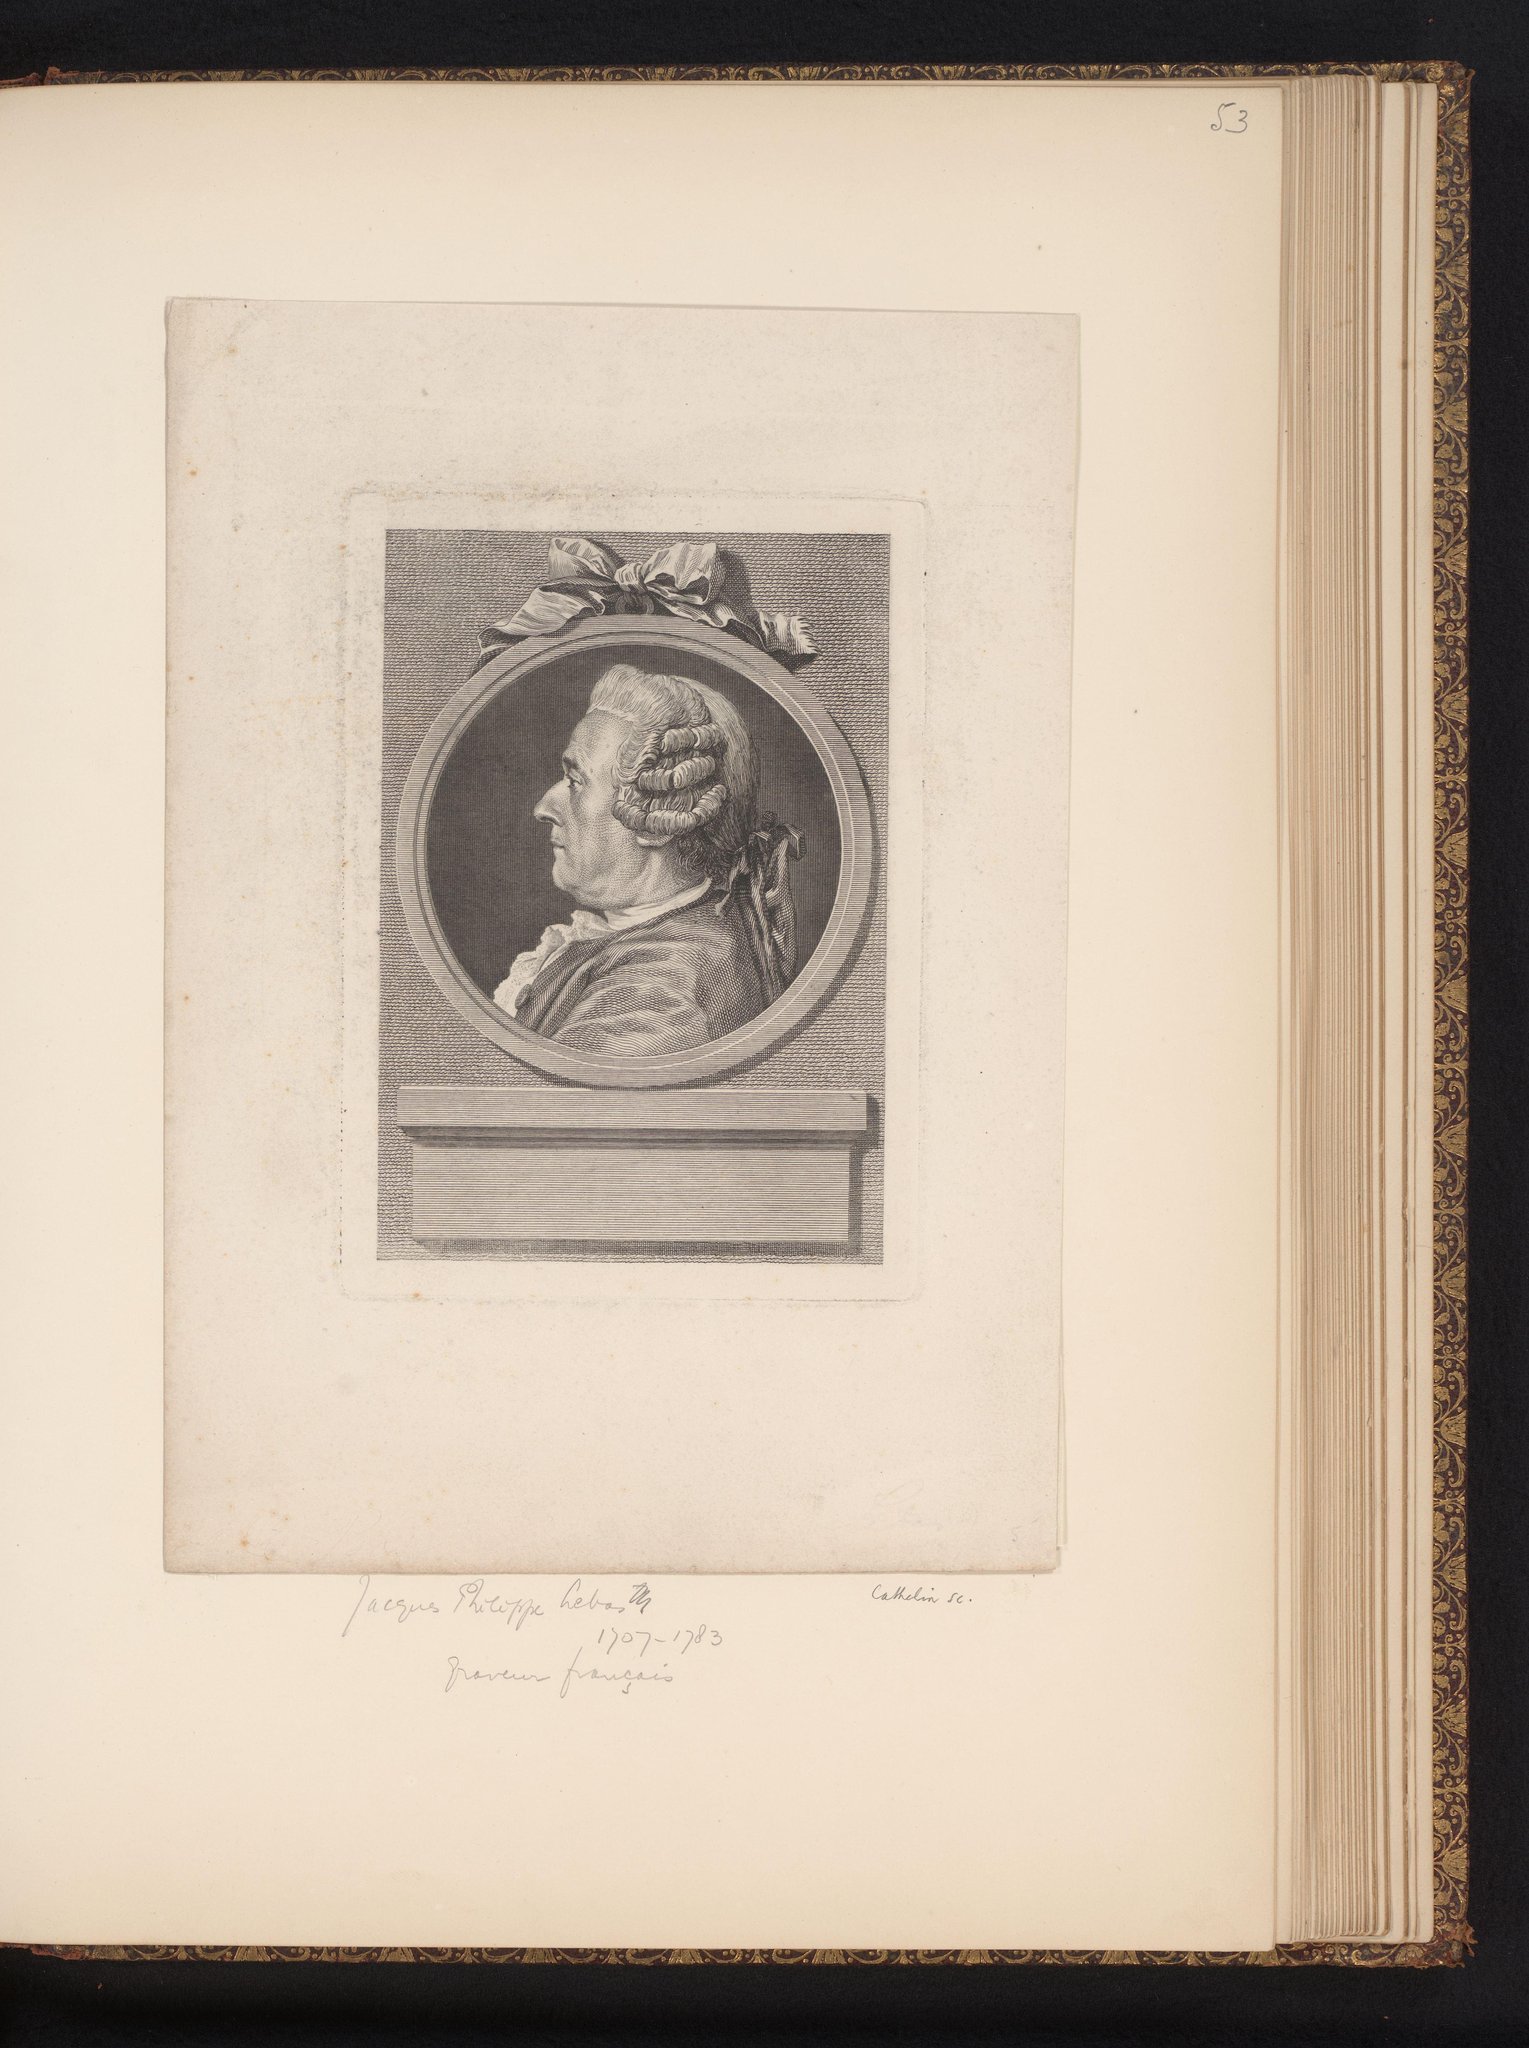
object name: album leaf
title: Portret van Jacques-Philippe Le Bas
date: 1762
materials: paper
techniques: engraving, etching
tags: paris, draughtsman, jacques-philippe le bas, historical persons, portrait, self-portrait of graphic artist